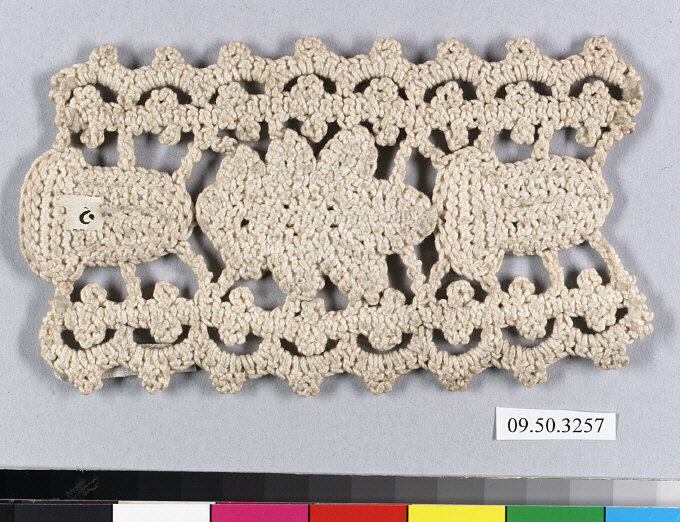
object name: sample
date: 1801-1900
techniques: crochet